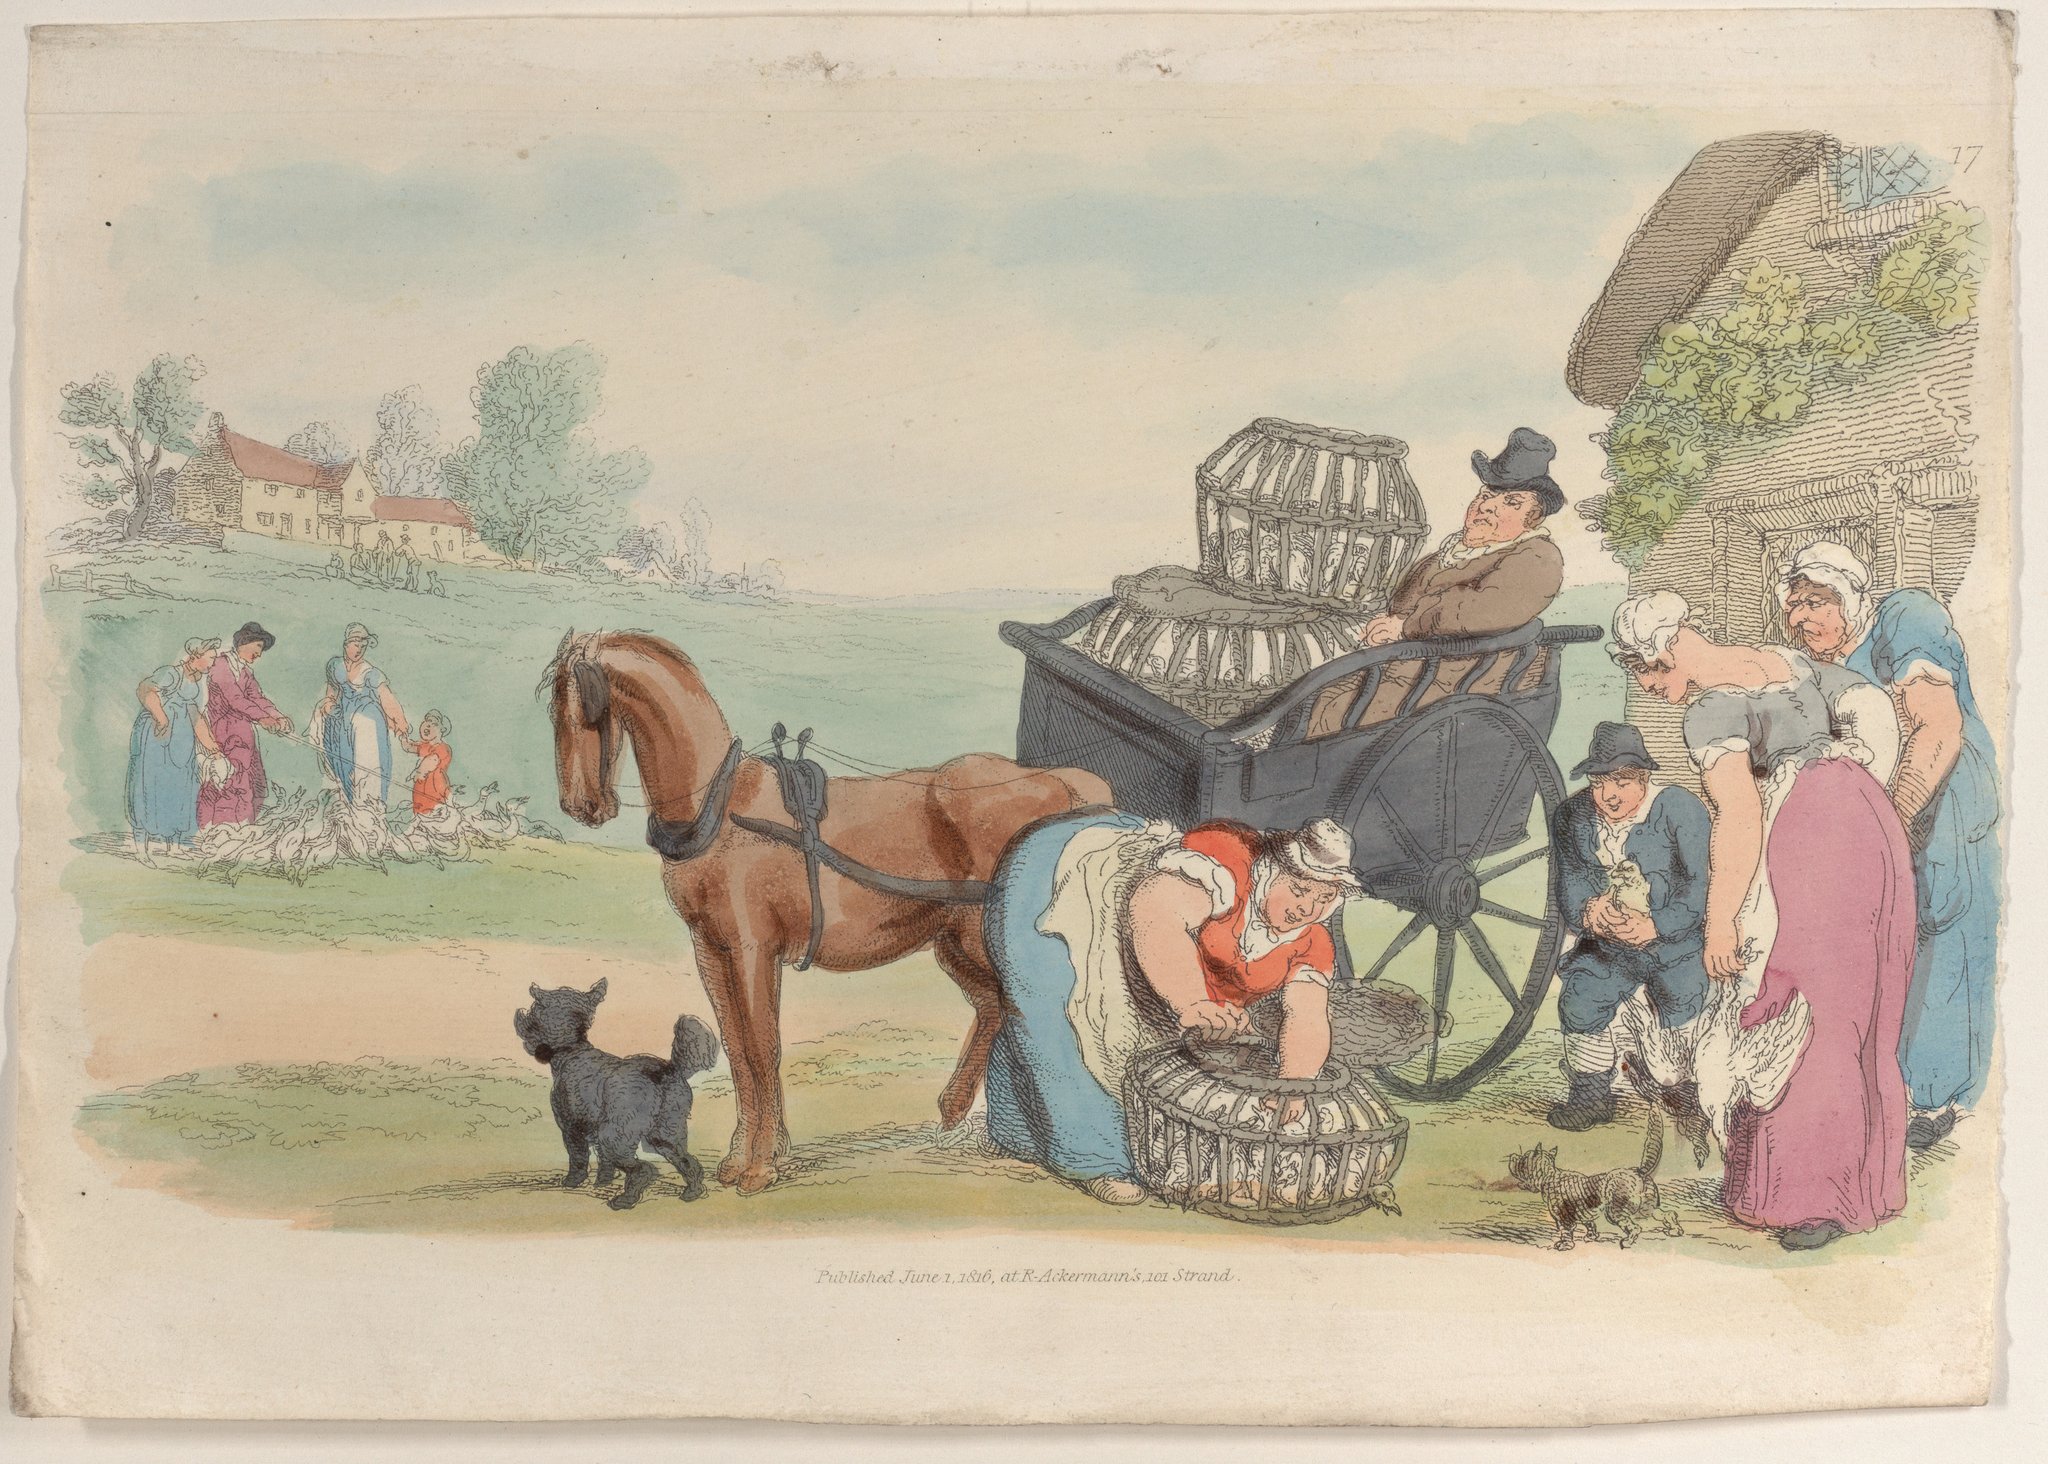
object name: print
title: Plate 17, from "World in Miniature"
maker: thomas rowlandson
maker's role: artist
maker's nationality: british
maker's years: 1757-1827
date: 1816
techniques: etching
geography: london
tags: birds,men,women,dogs,horses,carts